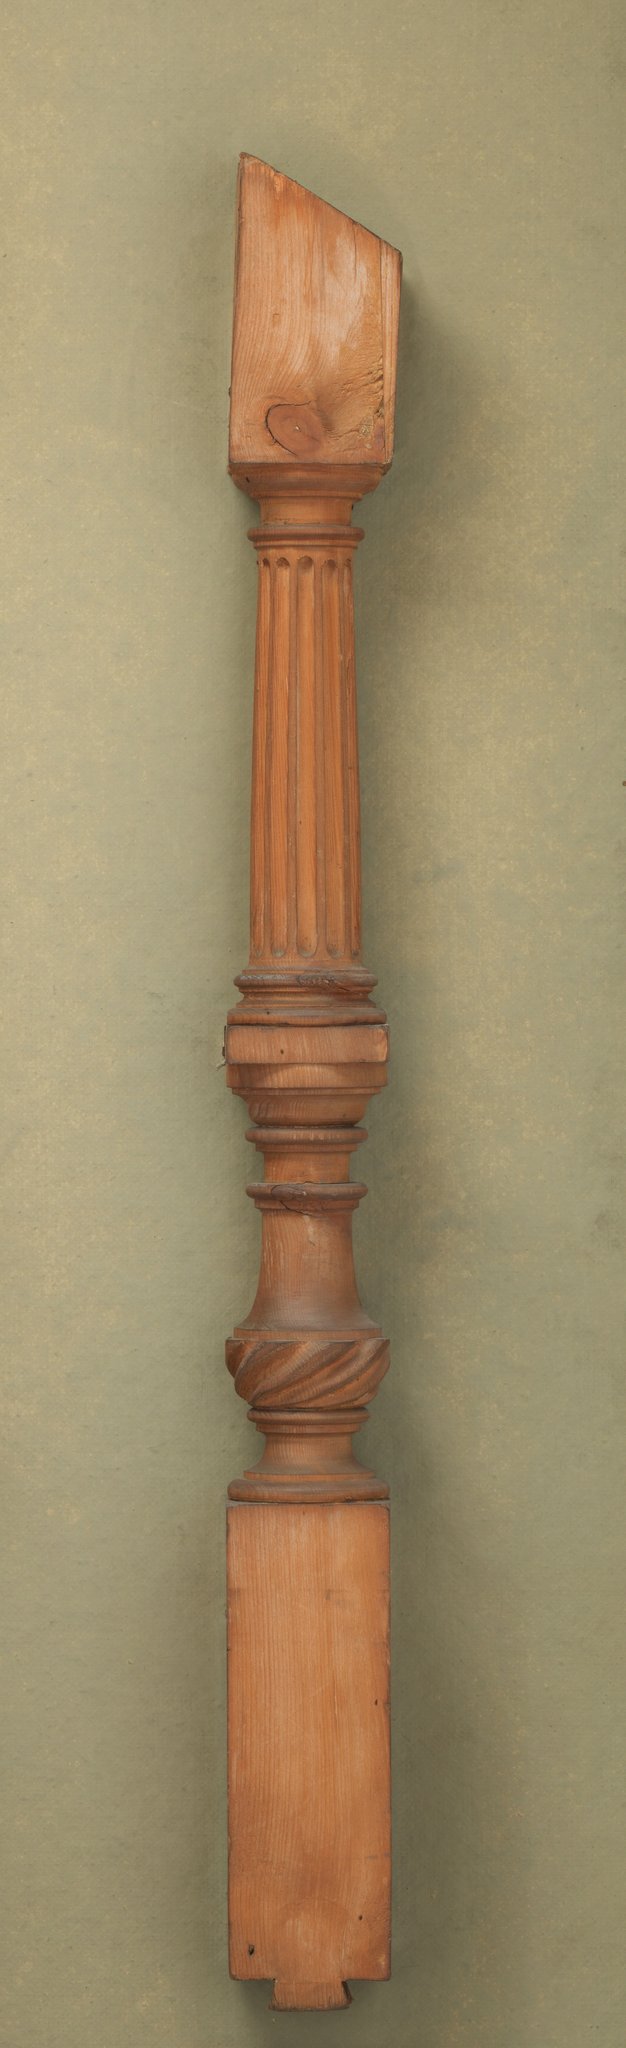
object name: baluster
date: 1734-1766